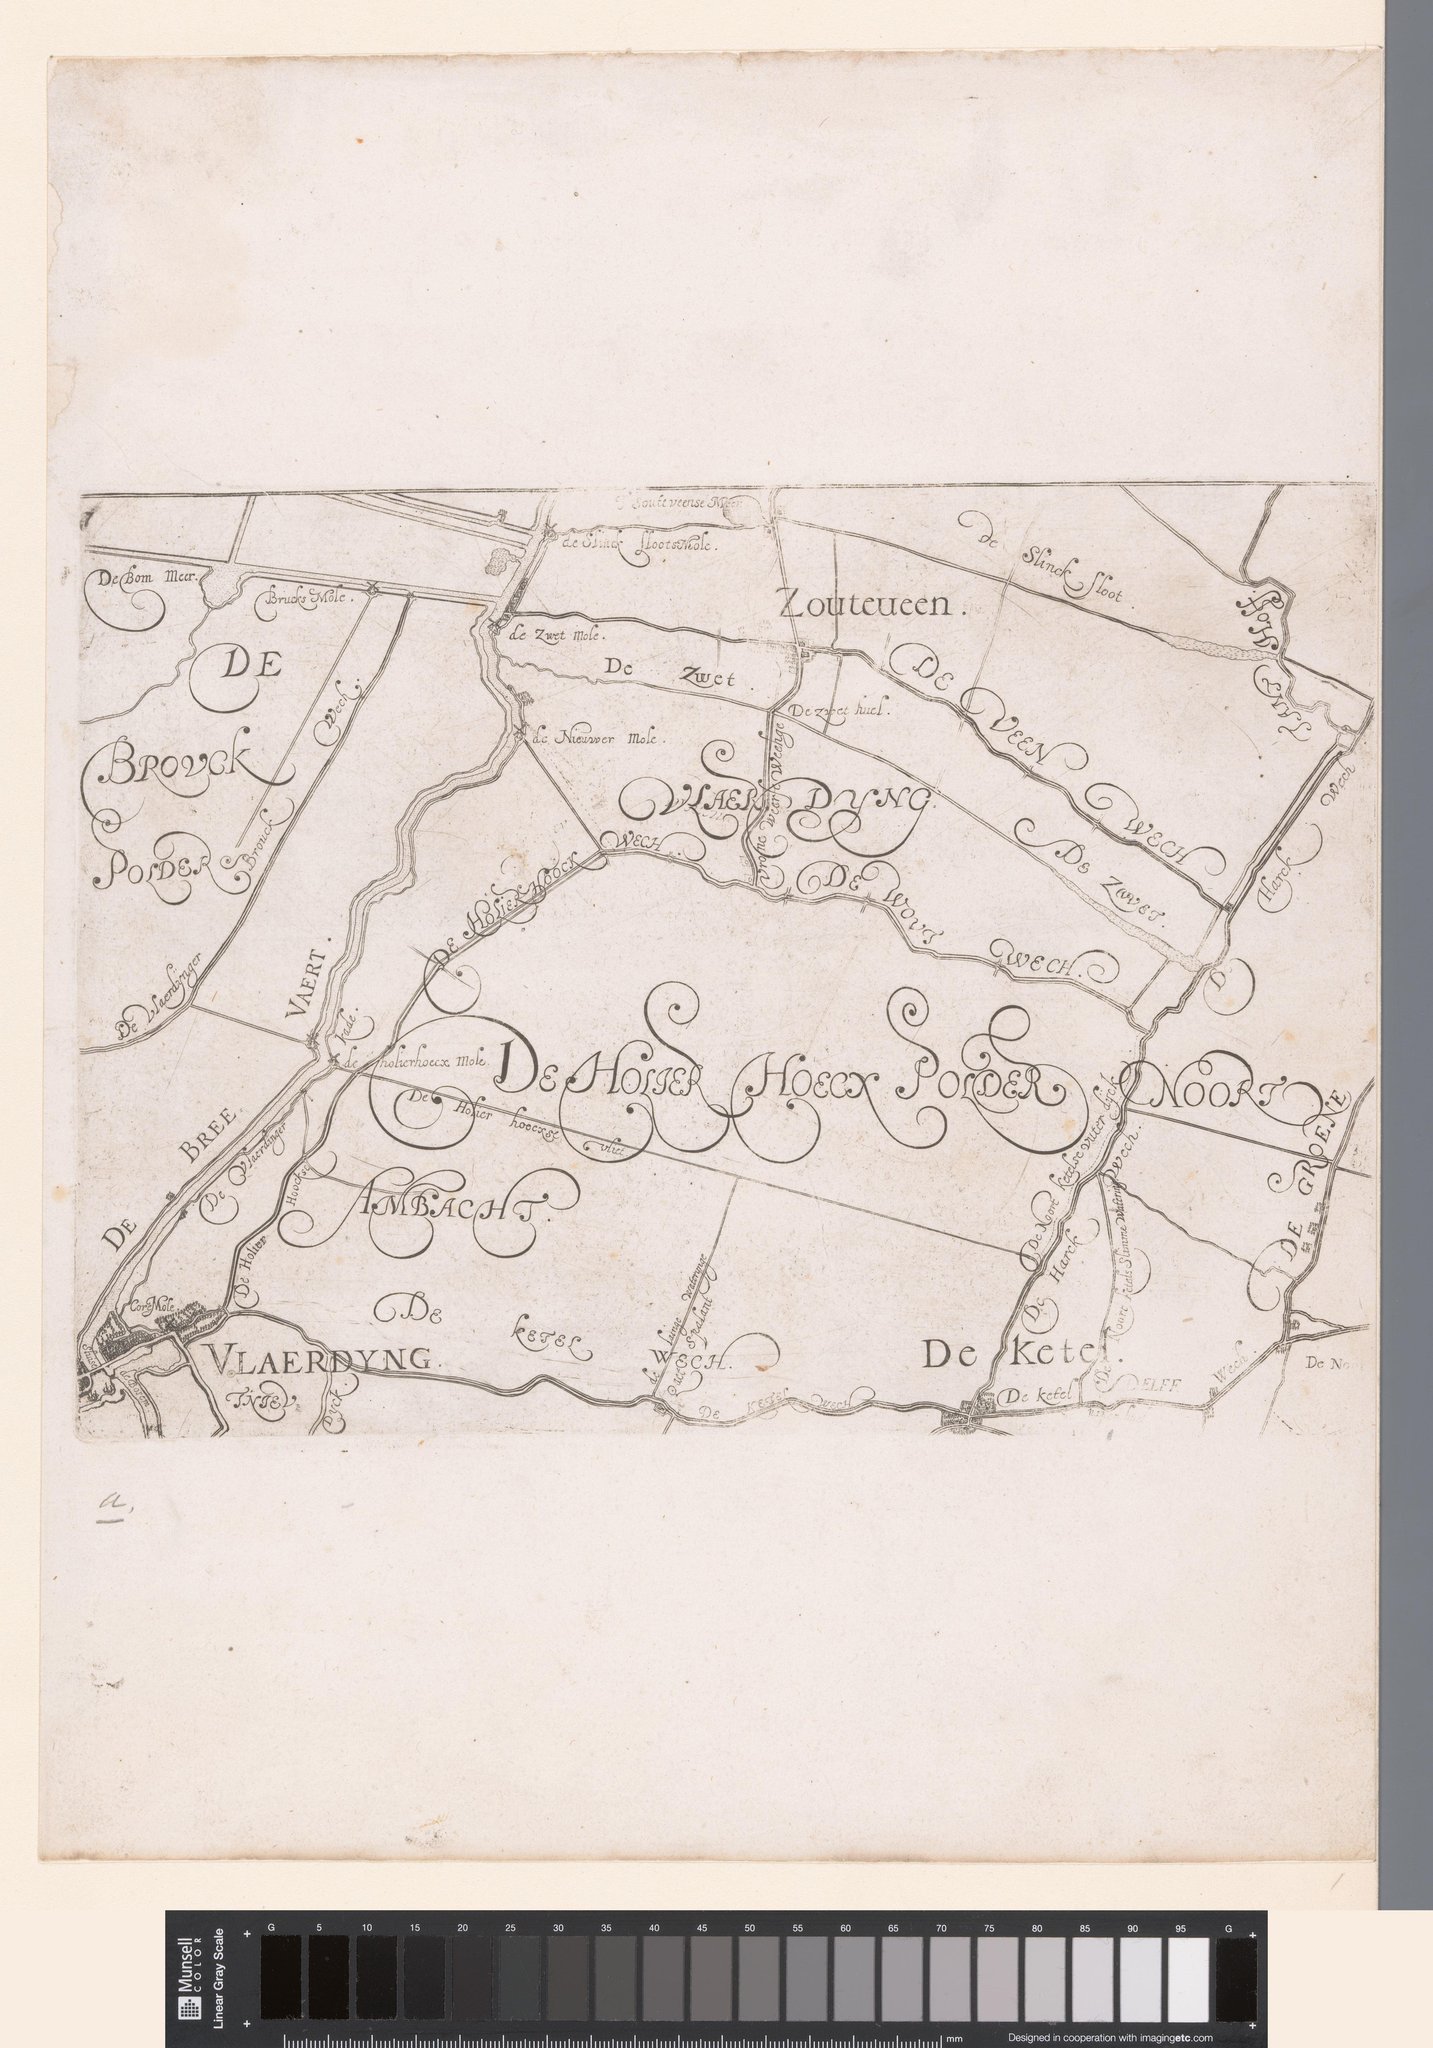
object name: map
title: Kaart van het Hoogheemraadschap van Schieland, met Vlaardingen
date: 1611-1635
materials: paper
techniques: engraving, etching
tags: maps of separate countries or regions, armorial bearing, heraldry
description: Deze kaart is tussen 1611 en 1635 vijf keer uitgegeven zonder dat de platen zijn bijgewerkt. Onduidelijk tot welke uitgave dit exemplaar behoort.